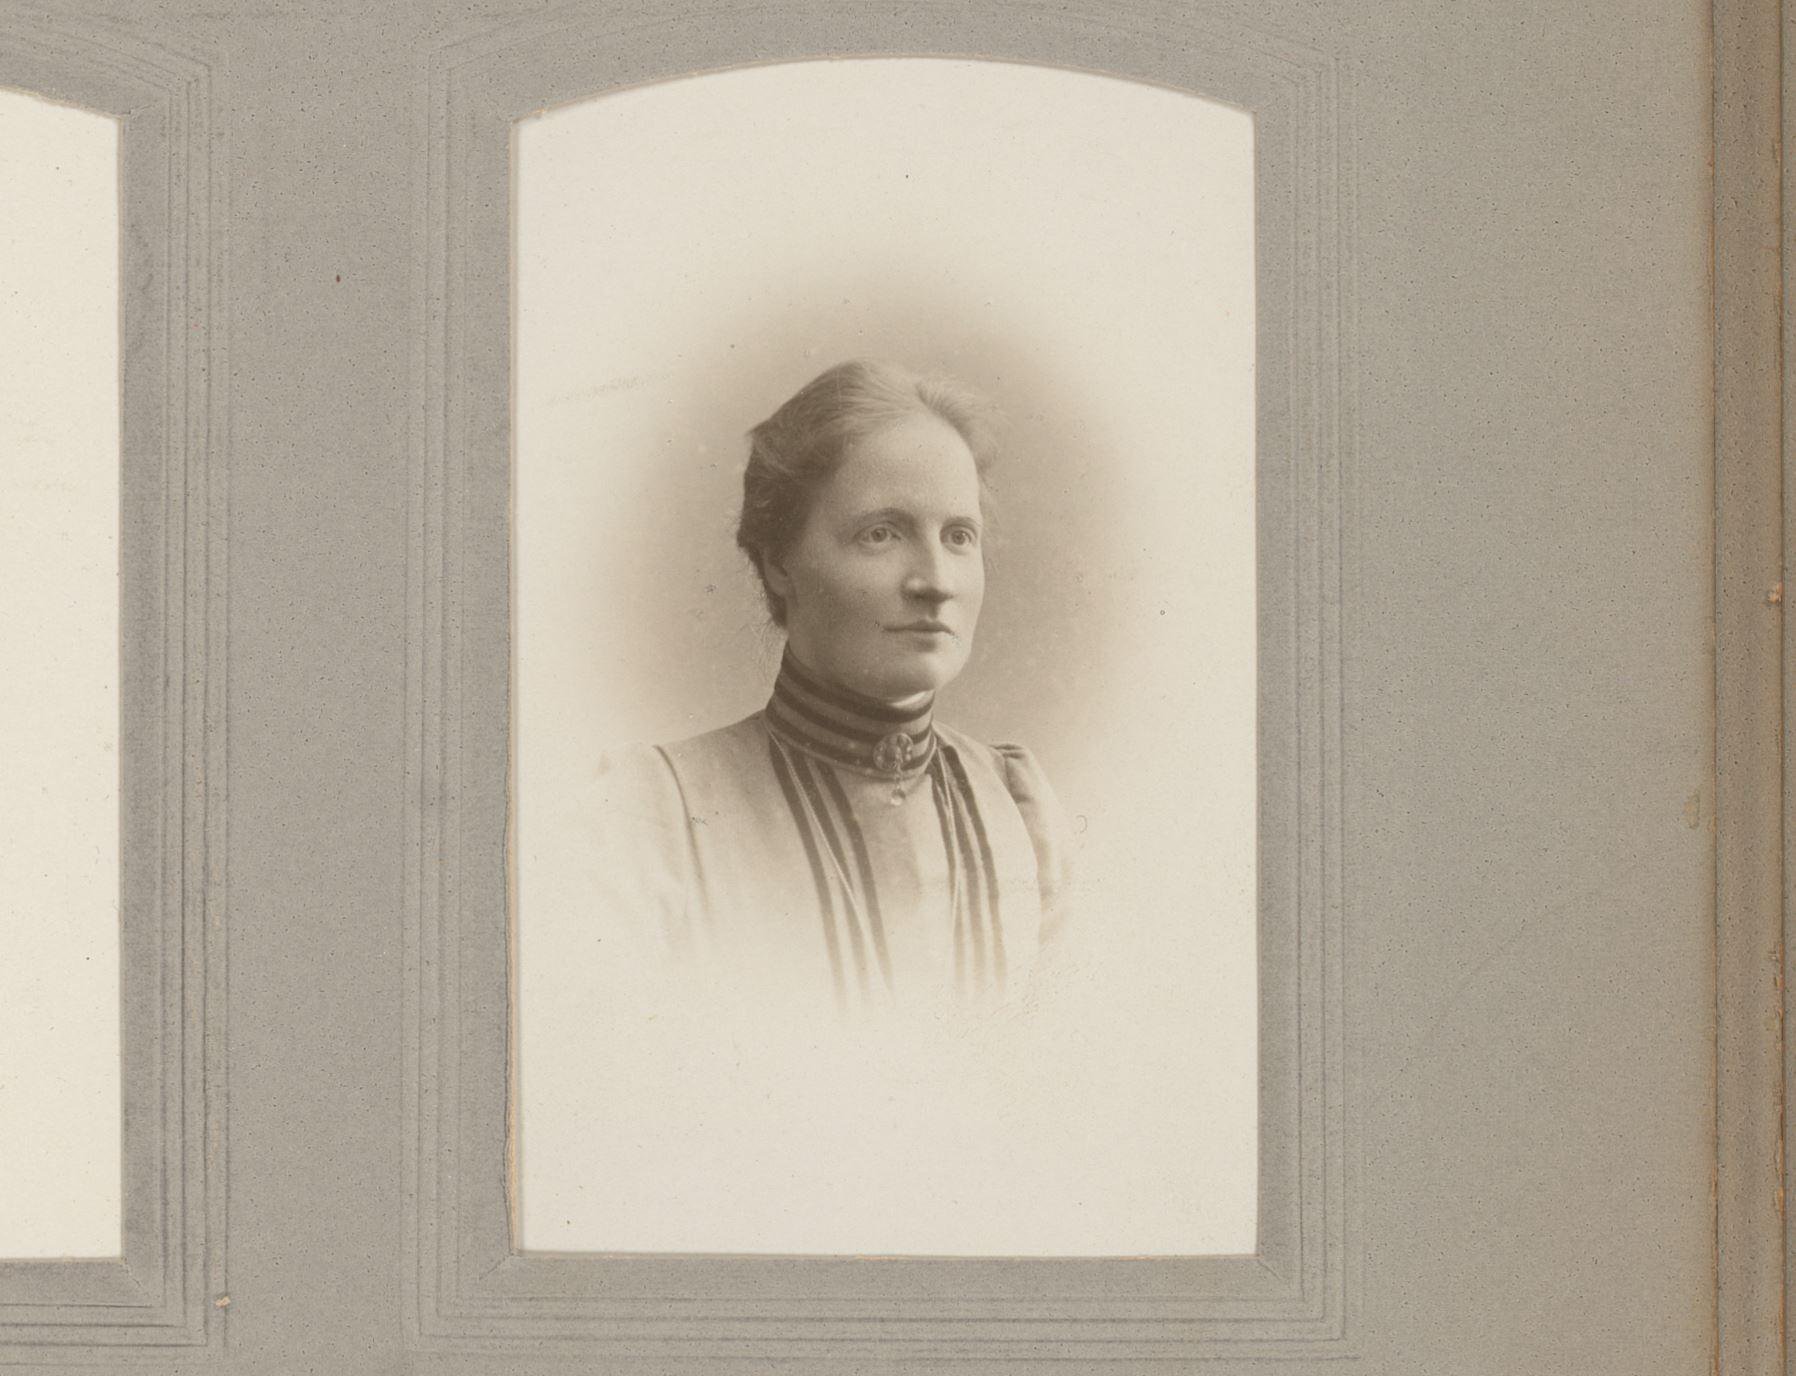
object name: album leaf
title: Portret van een vrouw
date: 1880-1920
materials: cardboard, photographic support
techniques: collodion silver print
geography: stockholm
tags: historical persons - bb - woman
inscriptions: inscription: ‘Wasa Atelieren/ Stockholm/ Uplandsgatan 17’